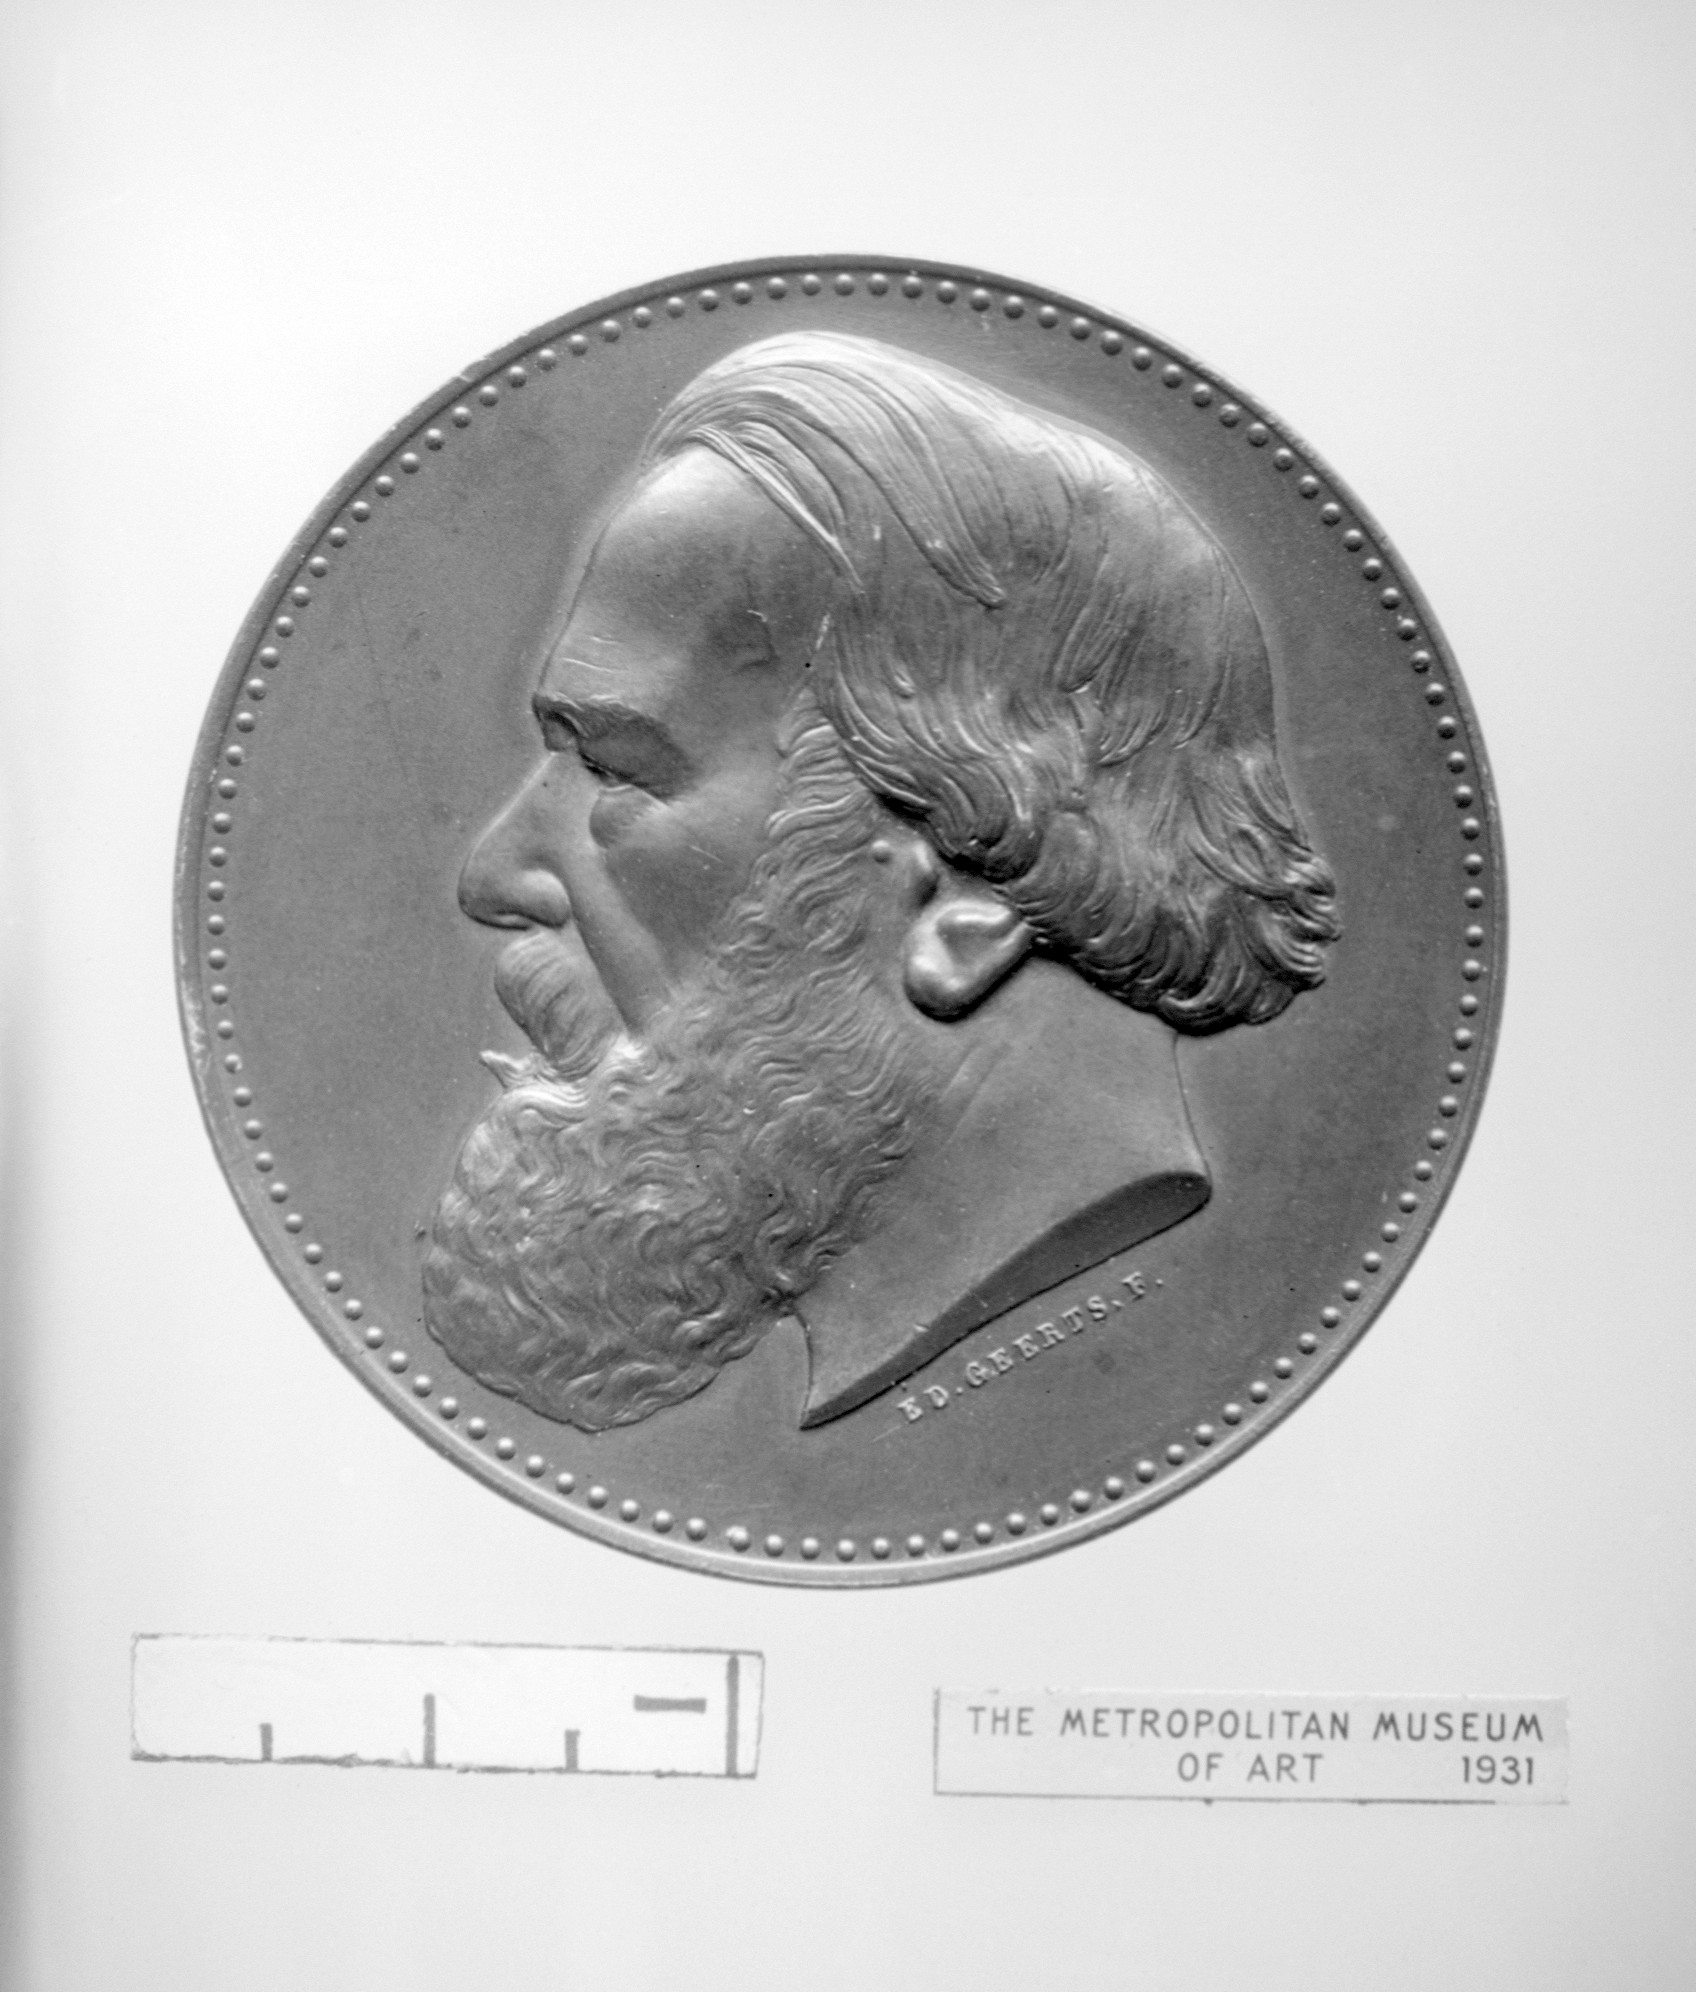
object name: medal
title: Professor Joseph Van Beneden of Louvain (1809–1894)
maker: edouard louis geerts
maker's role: artist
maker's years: 1826-1889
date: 1801-1900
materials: bronze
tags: men,profiles